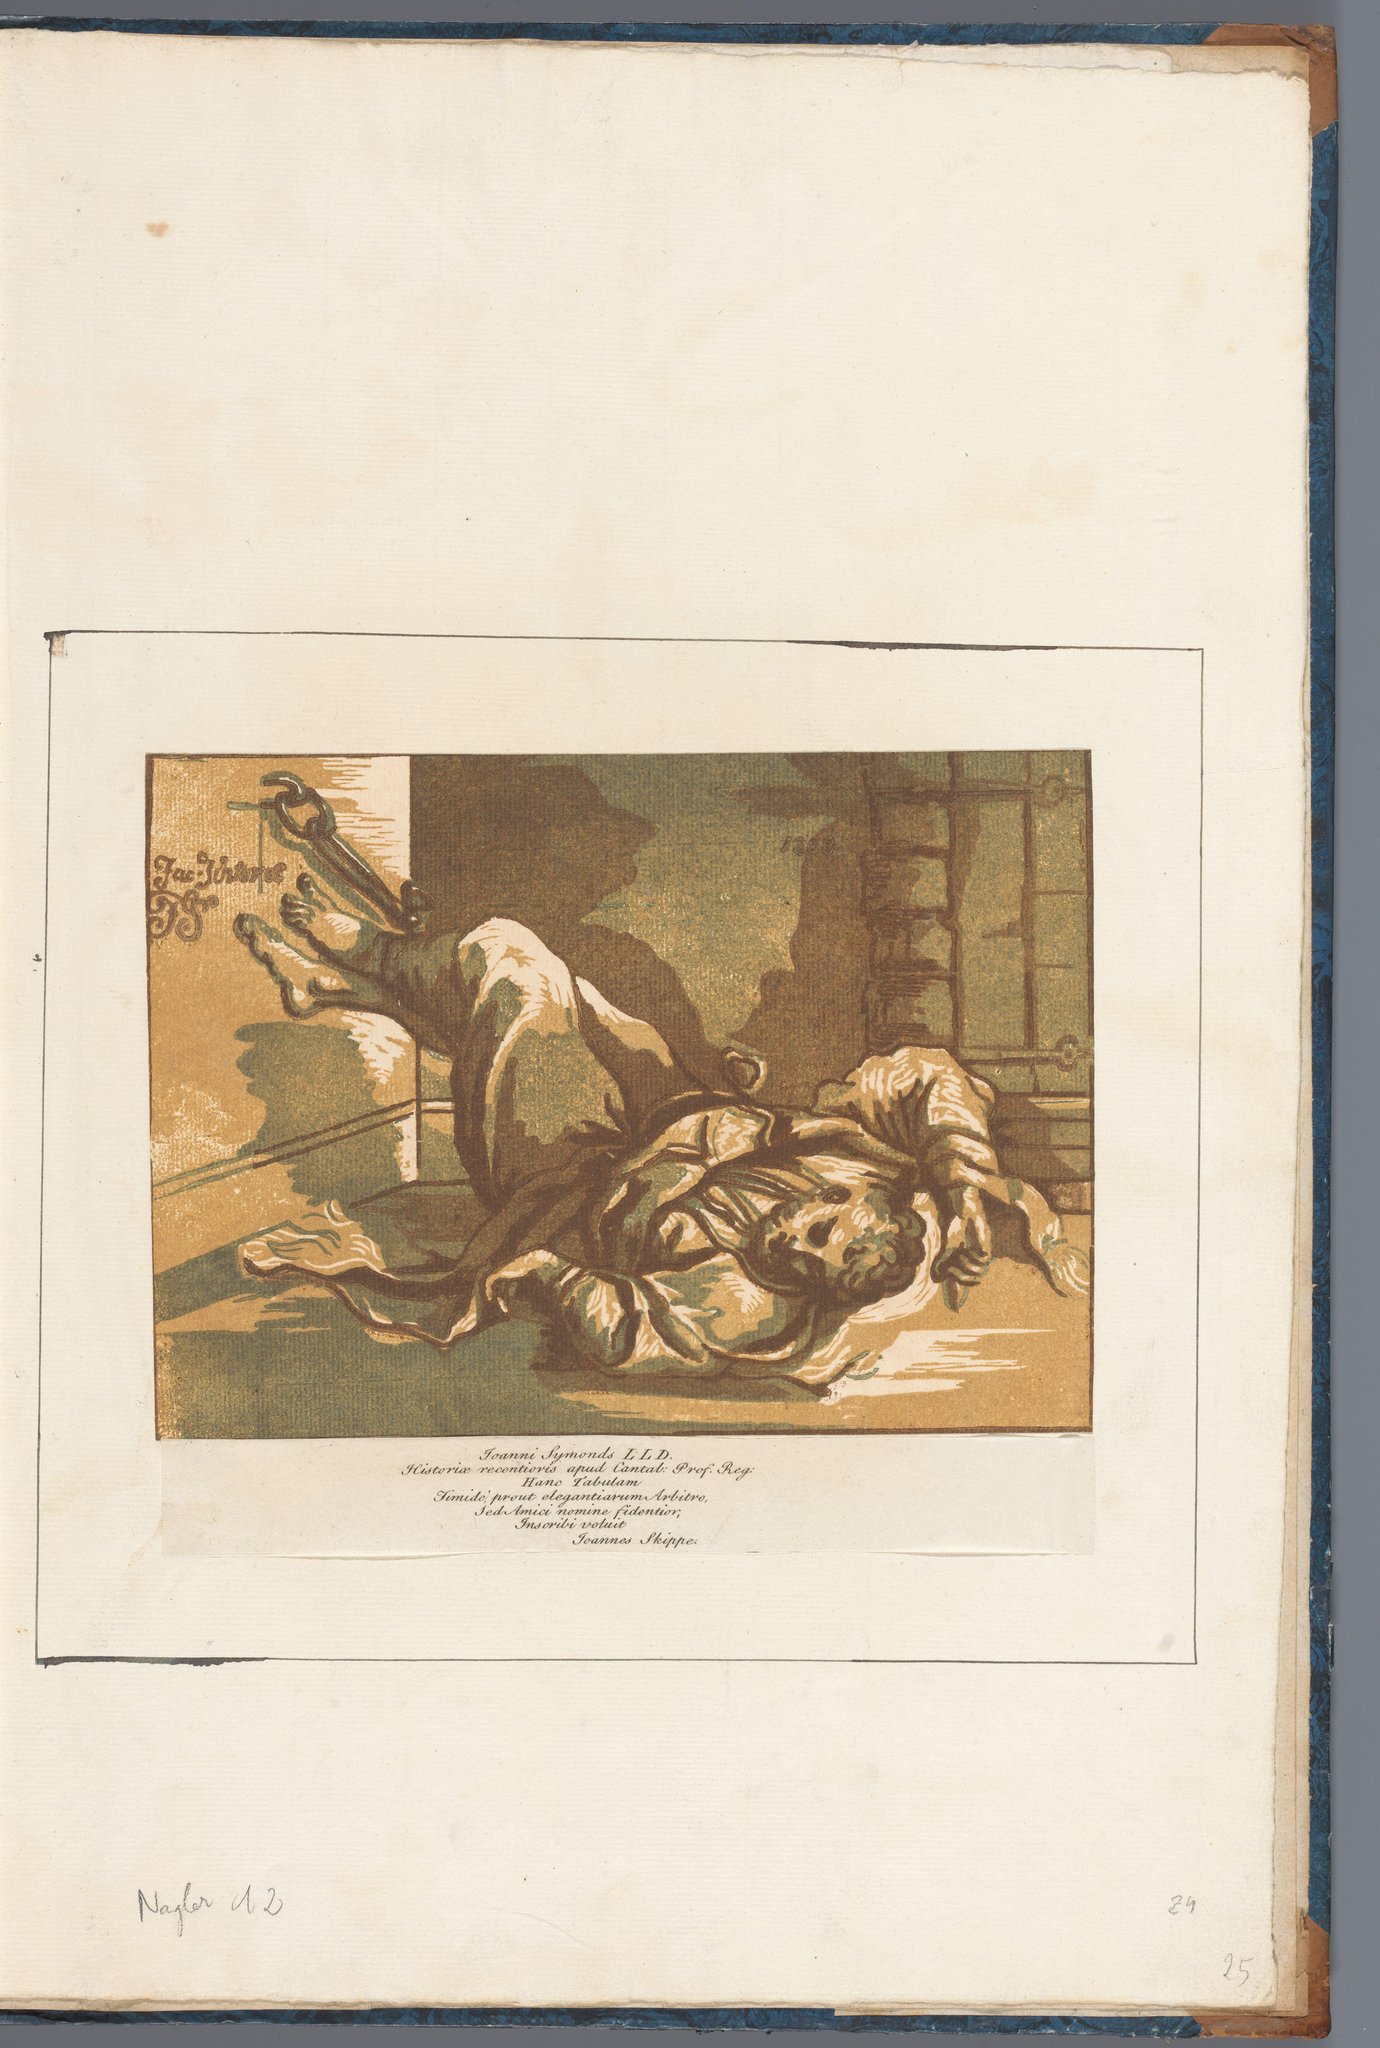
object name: print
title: Amicis suis necnon unicuique (...)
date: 1808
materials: ink, paper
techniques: woodcut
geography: england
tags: saints, prisoner; in fetters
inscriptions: date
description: Mannelijke heilige, geketend liggend in een cel. Met etiket met zevenregelige tekst in het Latijn waarin vermeld de naam: John Symonds. Onderdeel van een album met 26 ingeplakte clair-obscur houtsneden naar Italiaanse kunstenaars uit de zestiende eeuw.